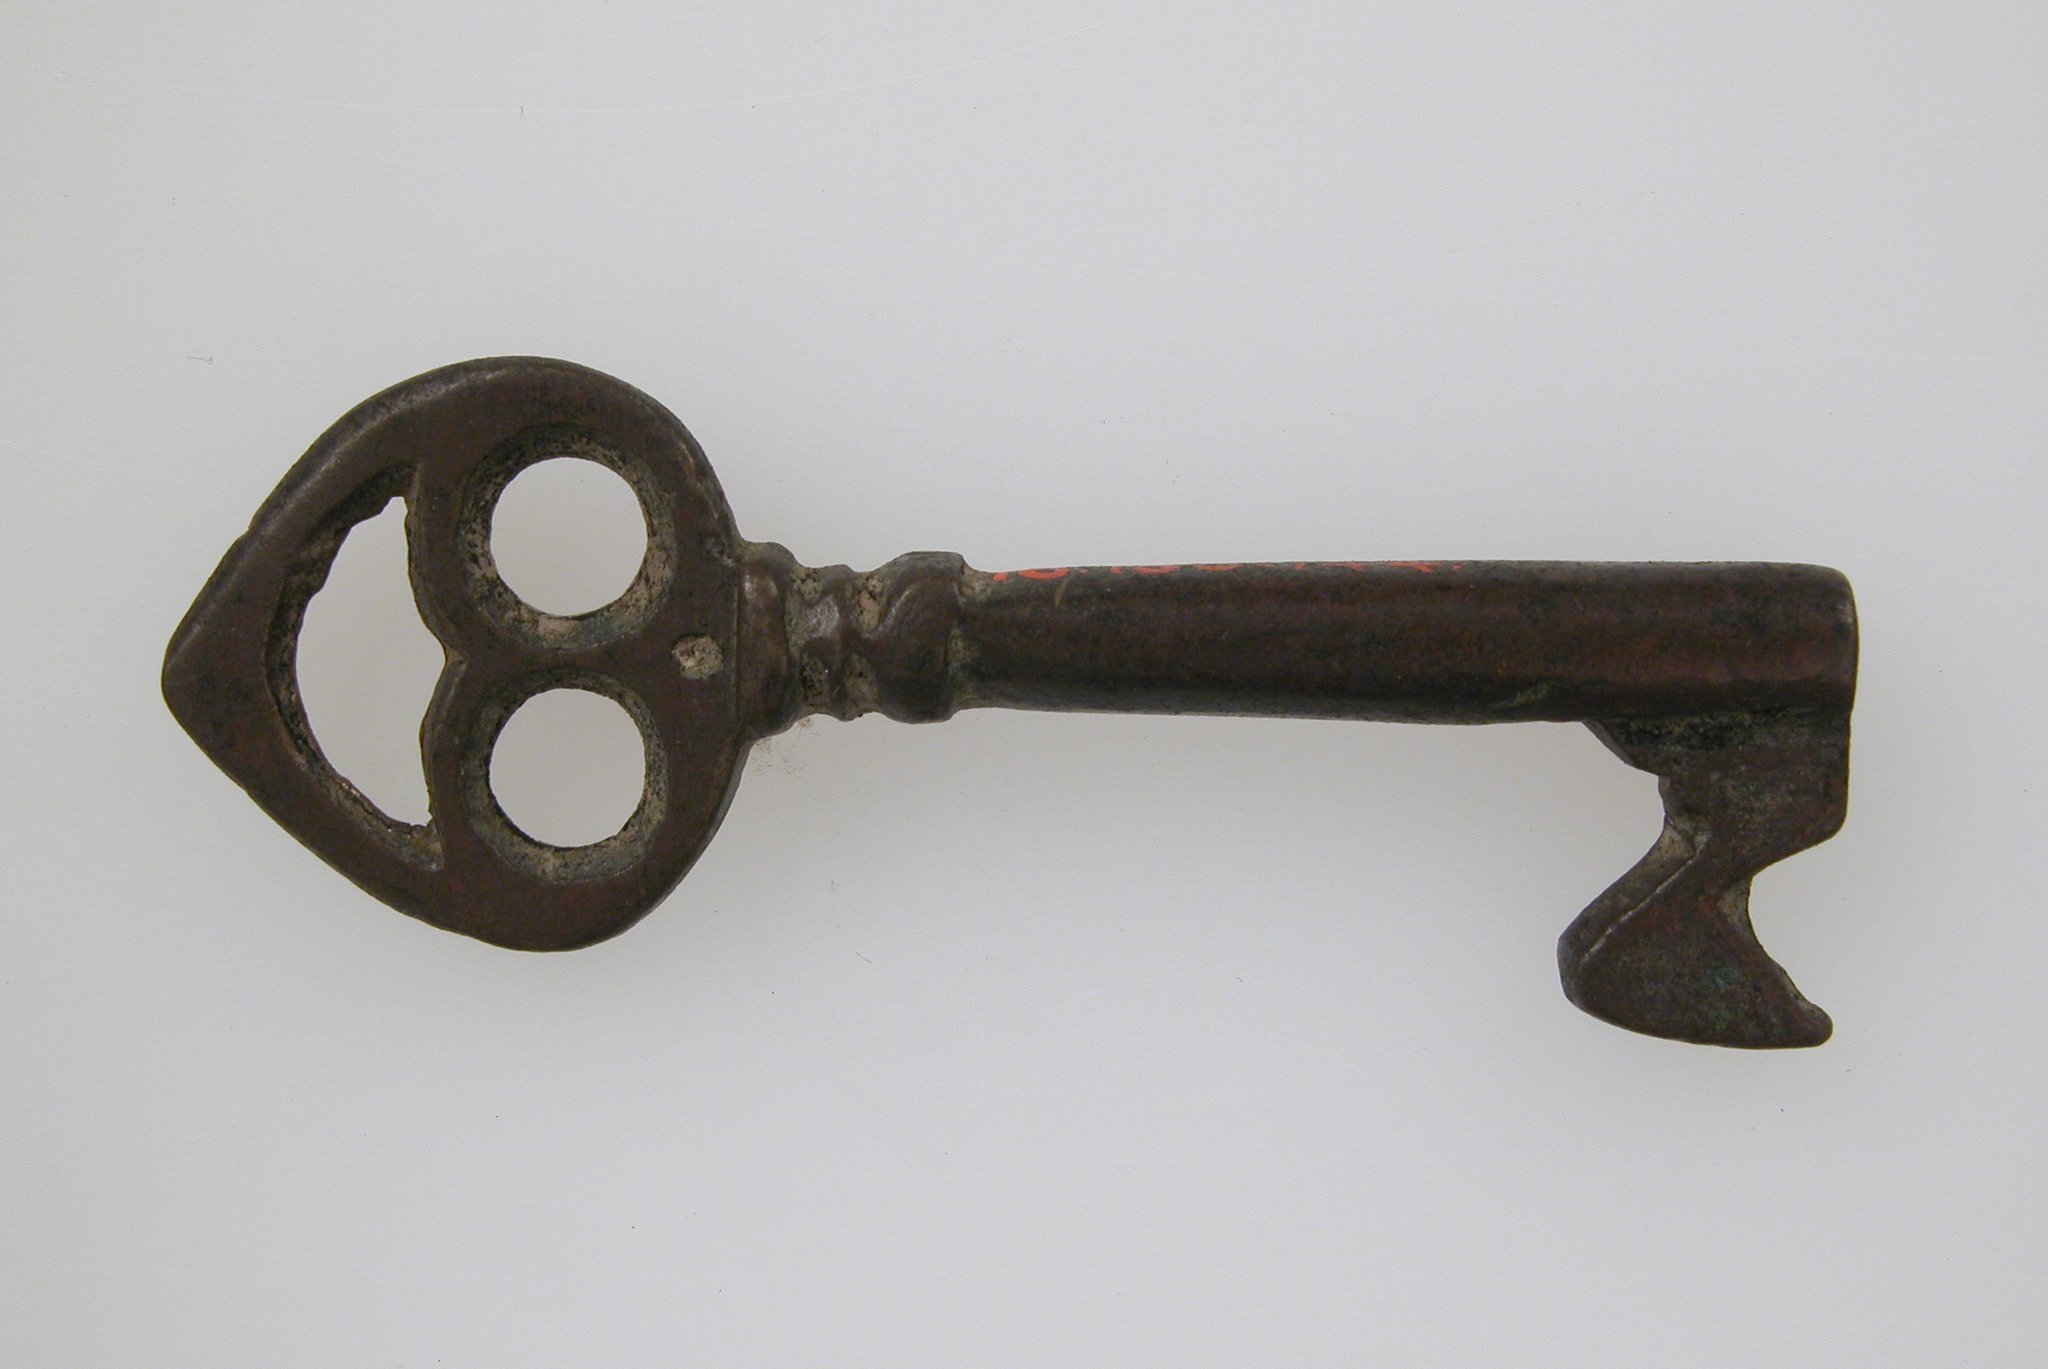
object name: key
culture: german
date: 1401-1500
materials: copper alloy